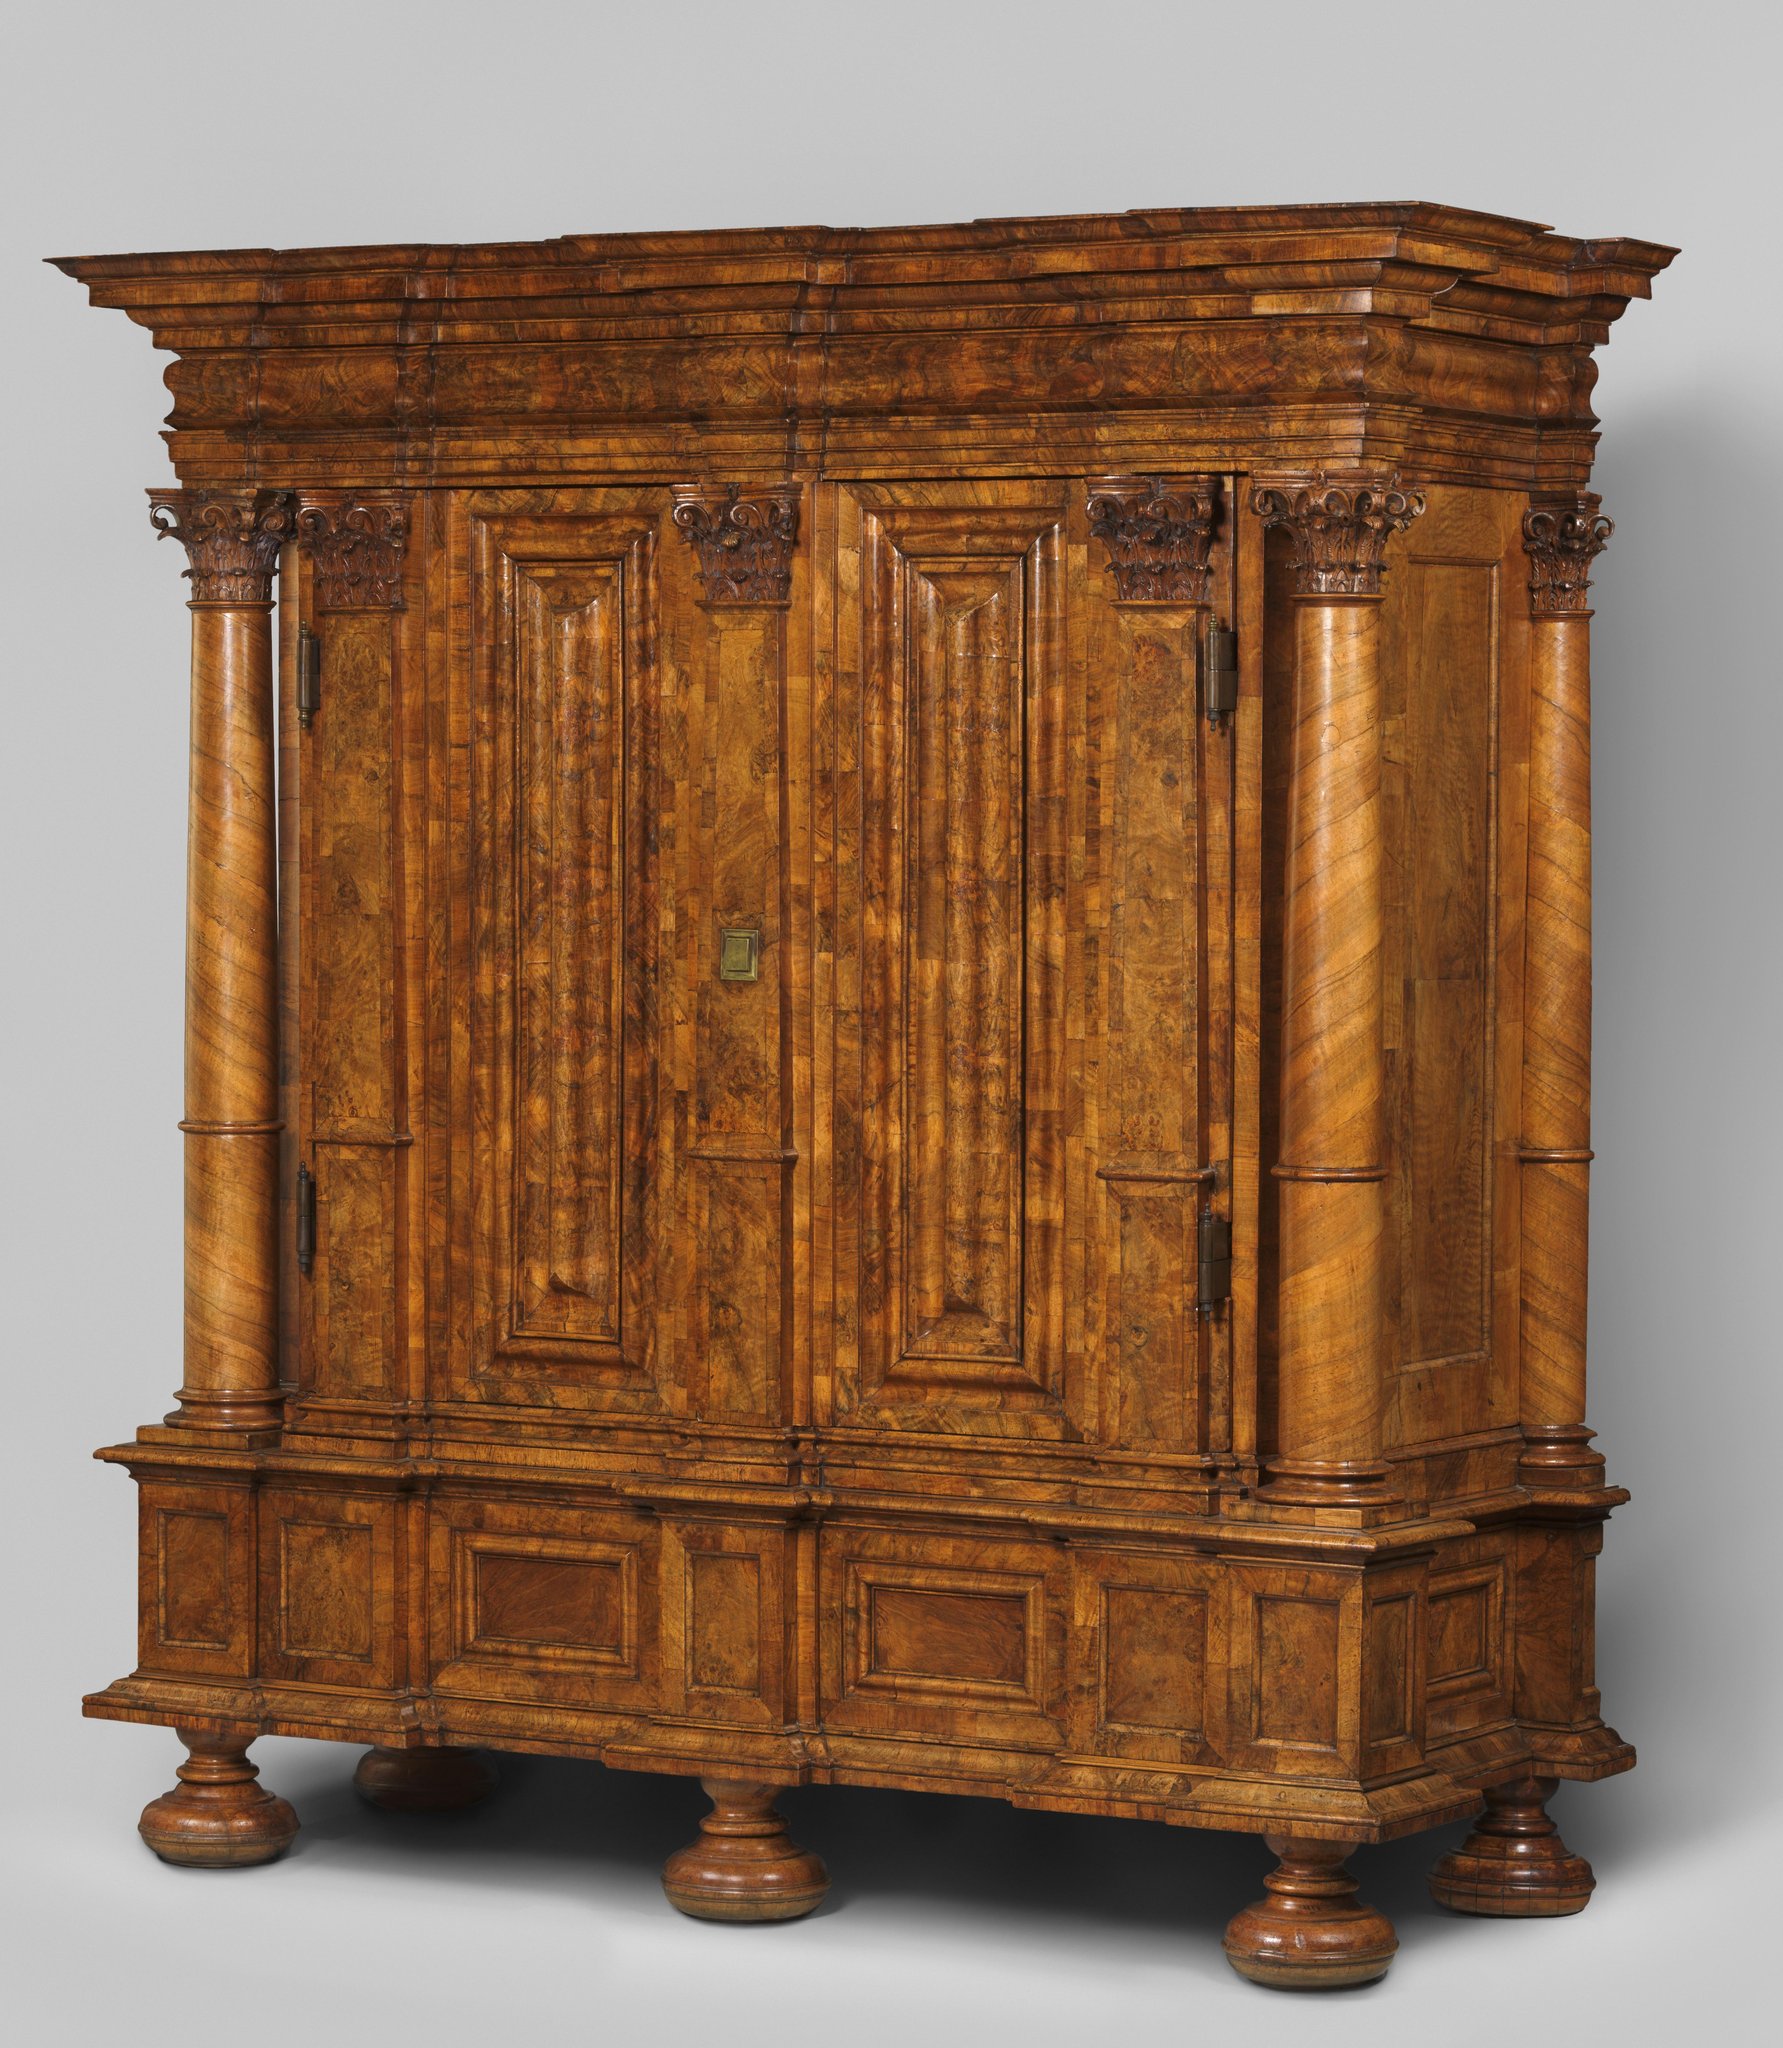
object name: case furniture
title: Kast van wortelnotenhout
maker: Anonymous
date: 1685-1700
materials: copper, wood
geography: frankfurt am main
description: Cupboard. Deal, veneered with burr walnut. Frankfurt am Main, c. 1690.